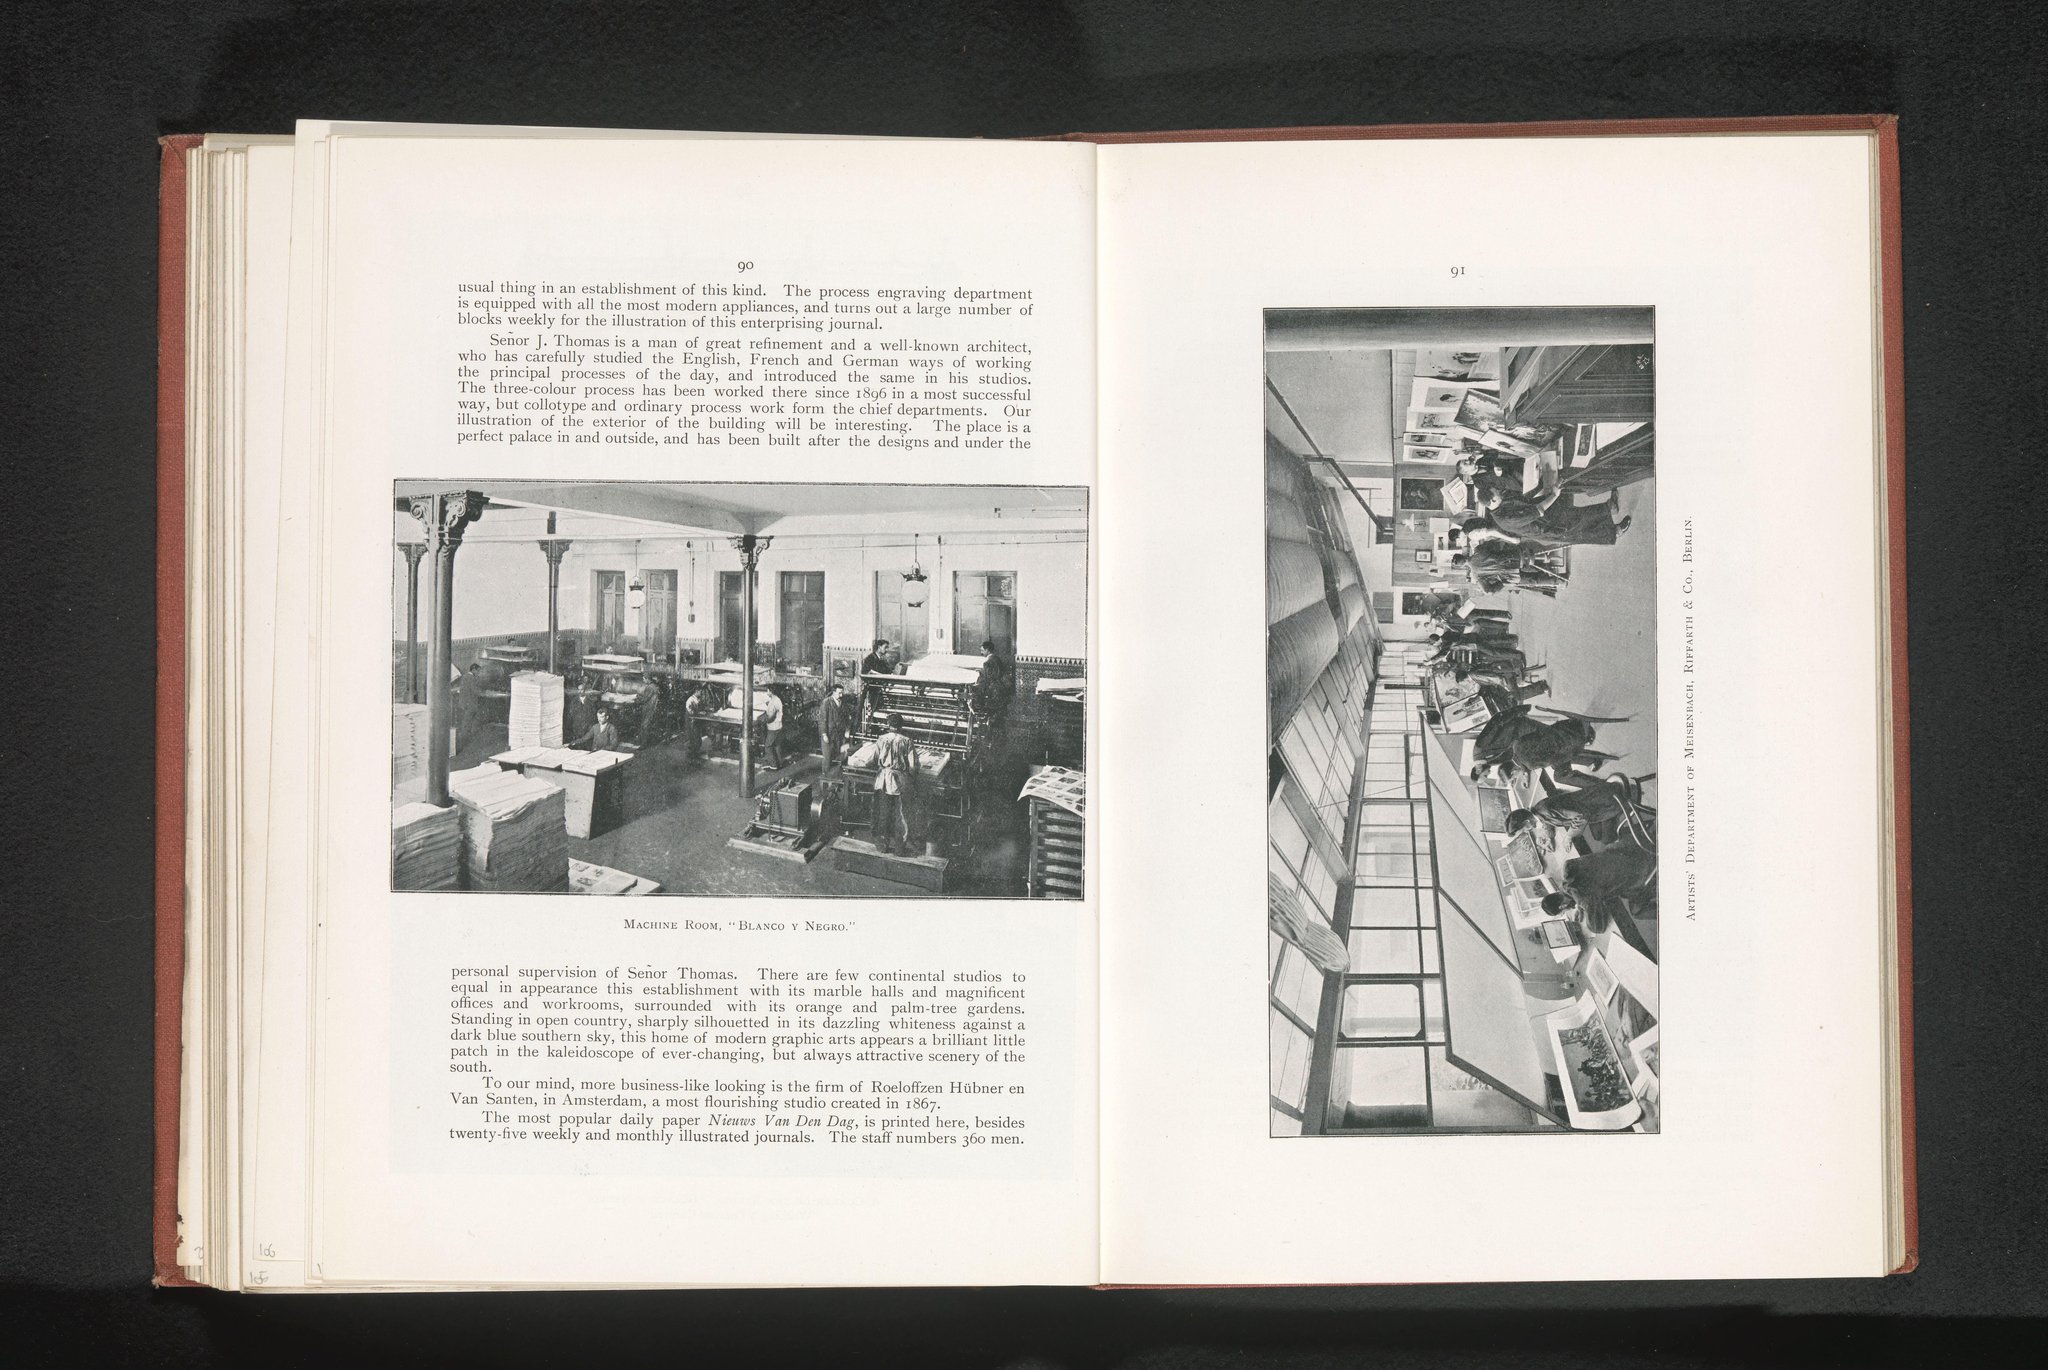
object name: page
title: Werkruimte van Meisenbach, Riffarth & Co. te Berlijn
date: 1895-1900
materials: paper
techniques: autotype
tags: printer, artist at work, in his workshop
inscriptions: inscription: ‘Artists' Department of Meisenbach, Riffarth & Co., Berlin’